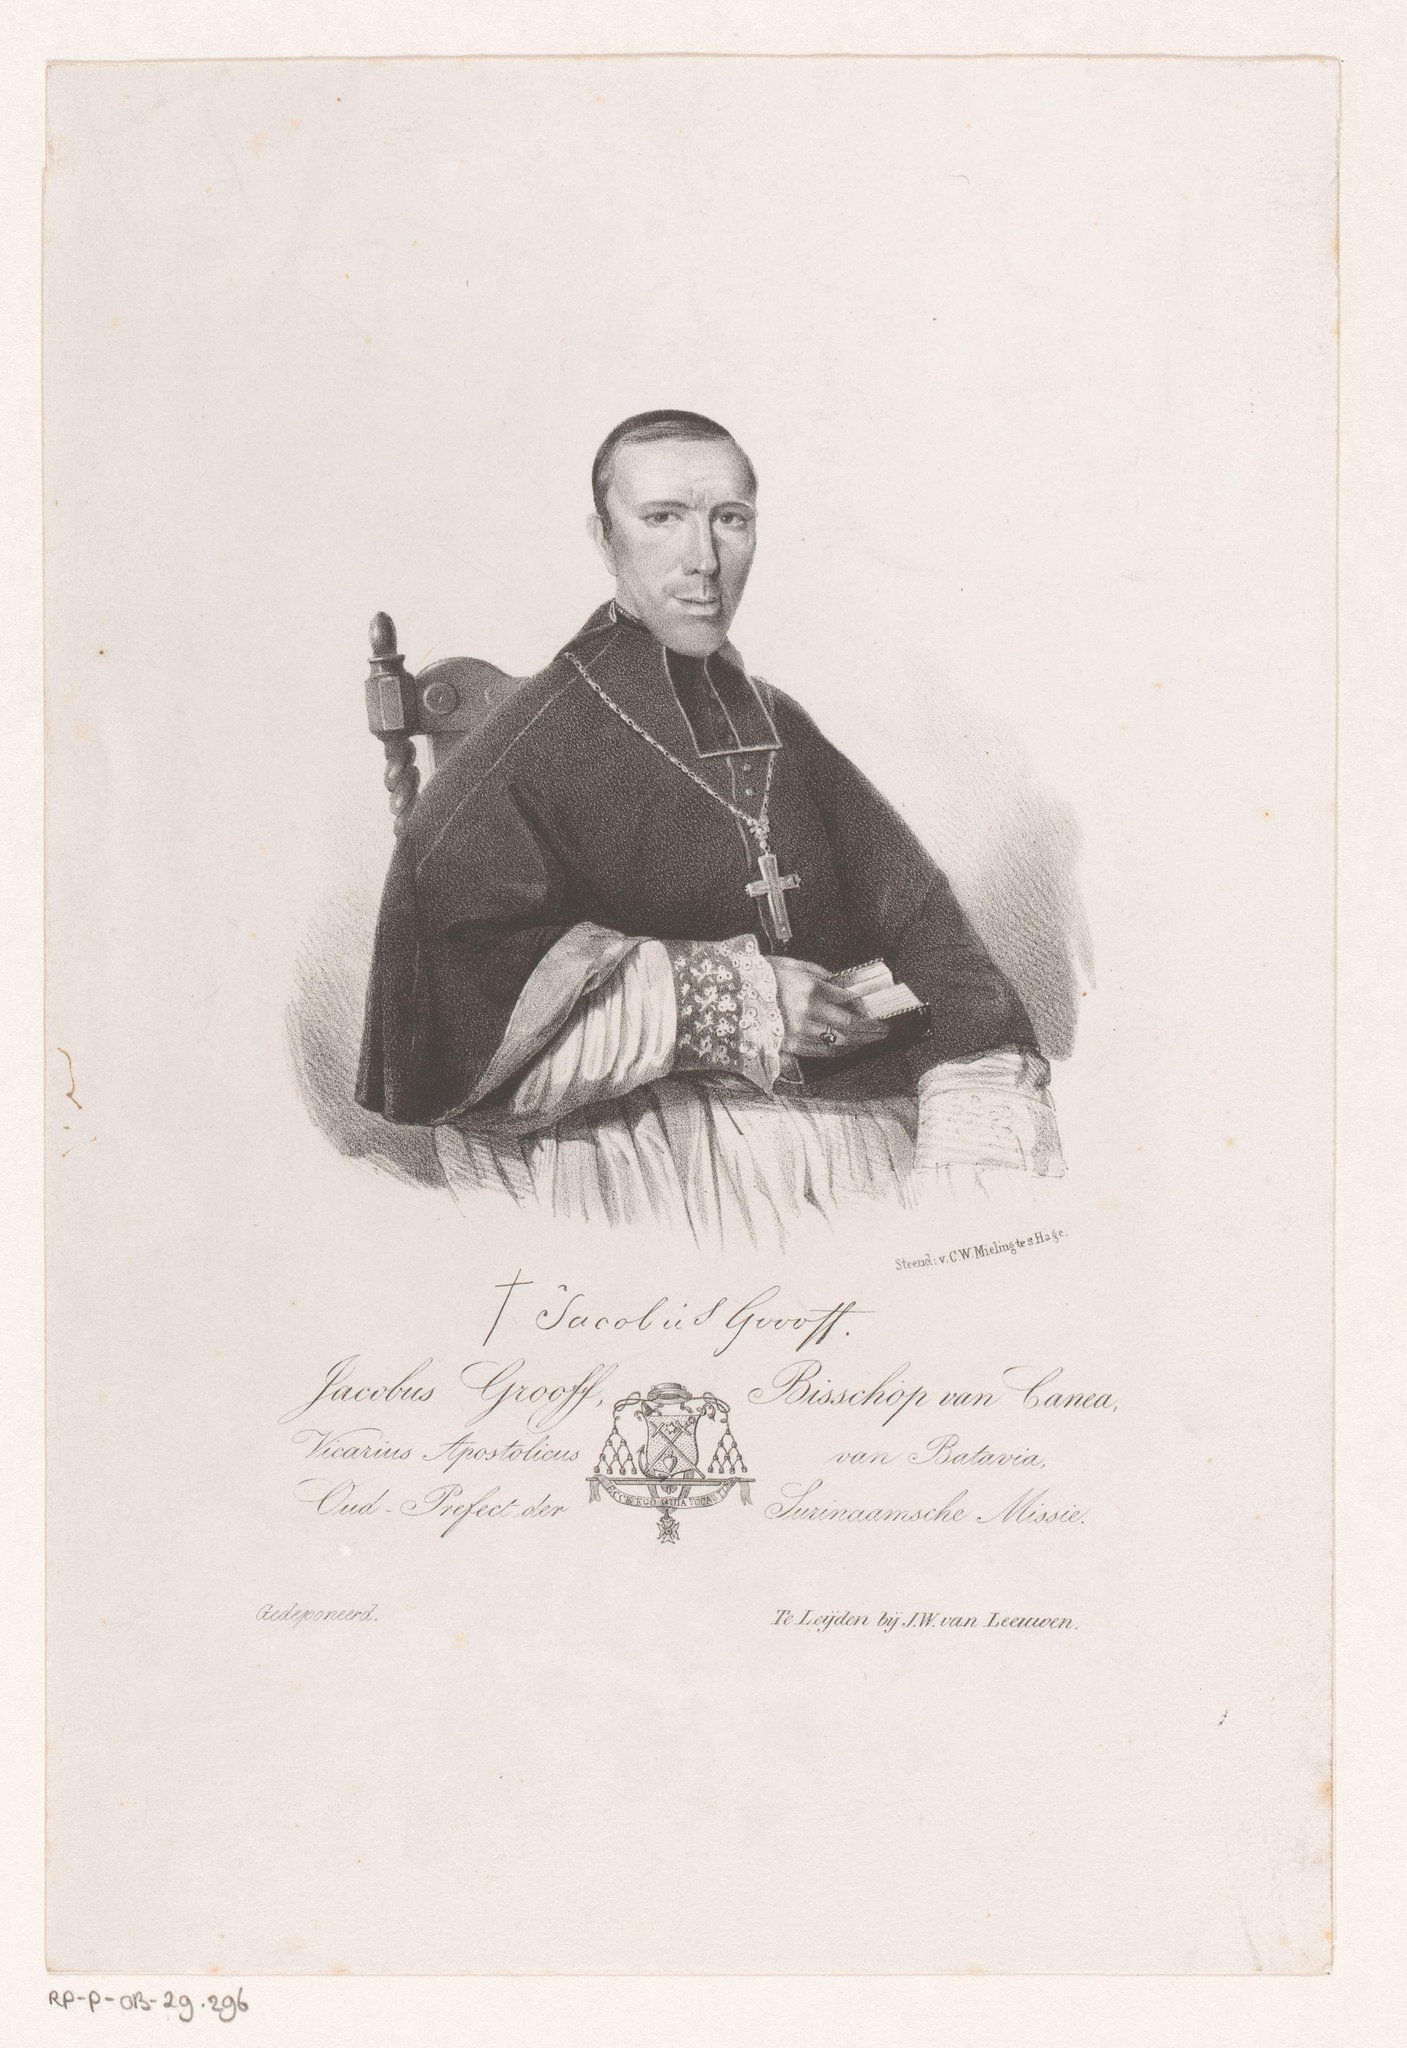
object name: print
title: Portret Jacobus Grooff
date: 1845-1847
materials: paper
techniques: lithograph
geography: leiden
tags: amsterdam, historical persons (+ (full) bust portrait)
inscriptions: collector's mark: Lugt 2228, : ‘Gedeponeerd.’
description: De geportretteerde draagt koorkleding en heeft een Bijbel in zijn rechterhand. Onder het portret zijn signatuur en functies.